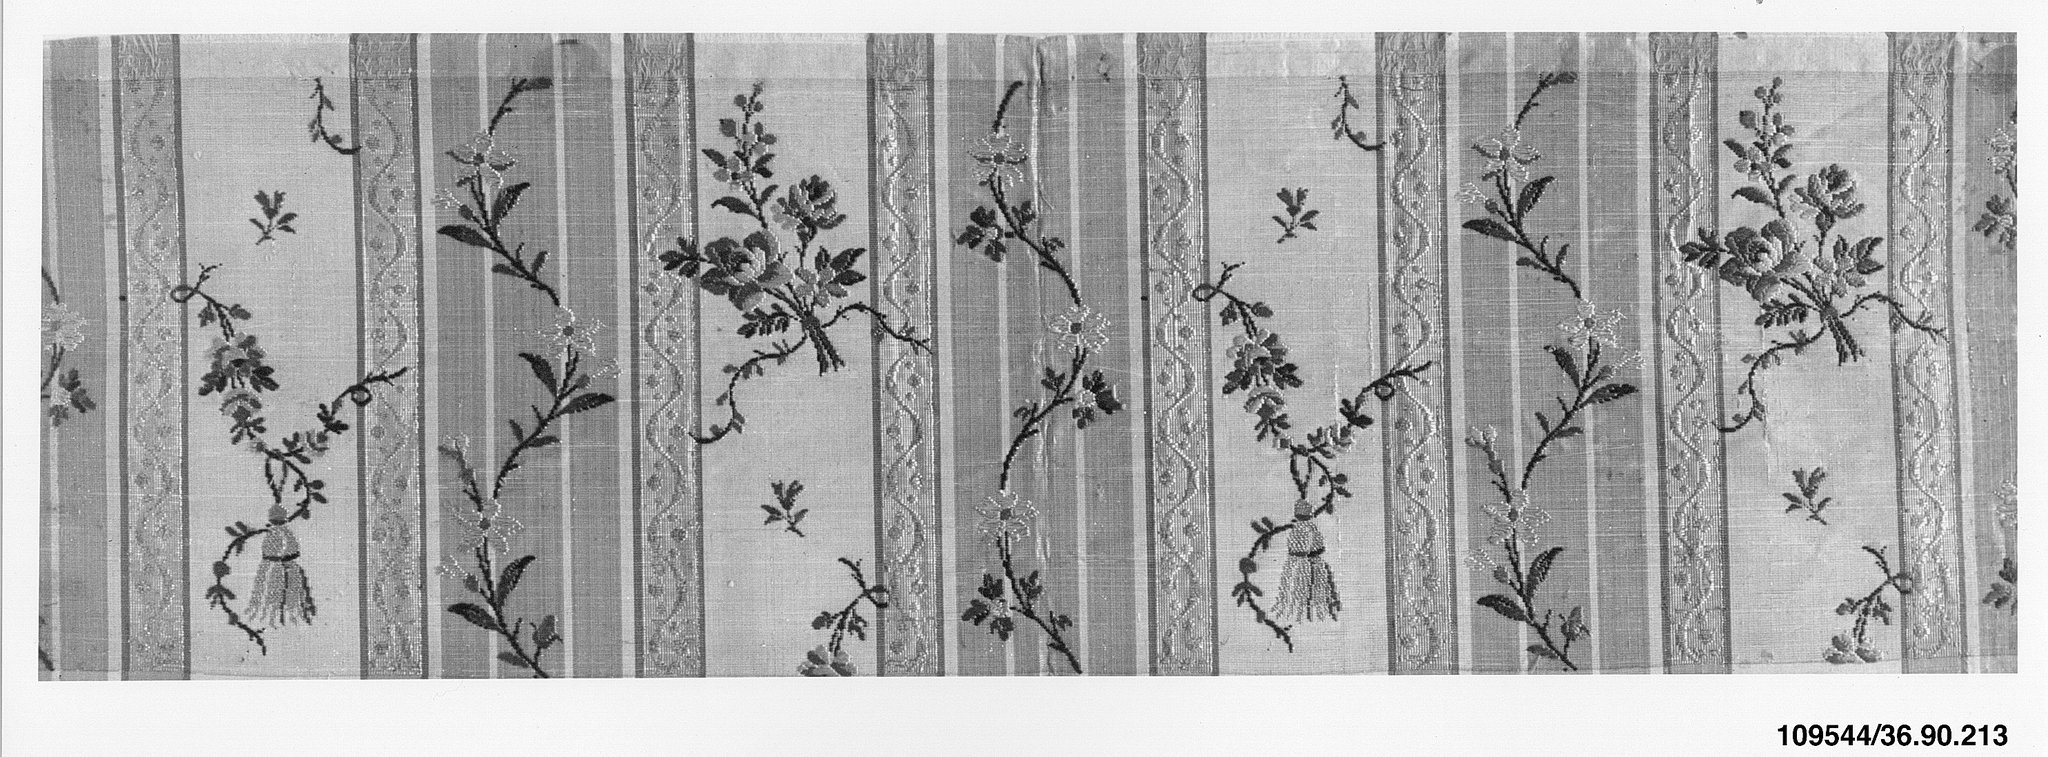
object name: piece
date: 1780-1790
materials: metal thread, silk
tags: flowers,leaves